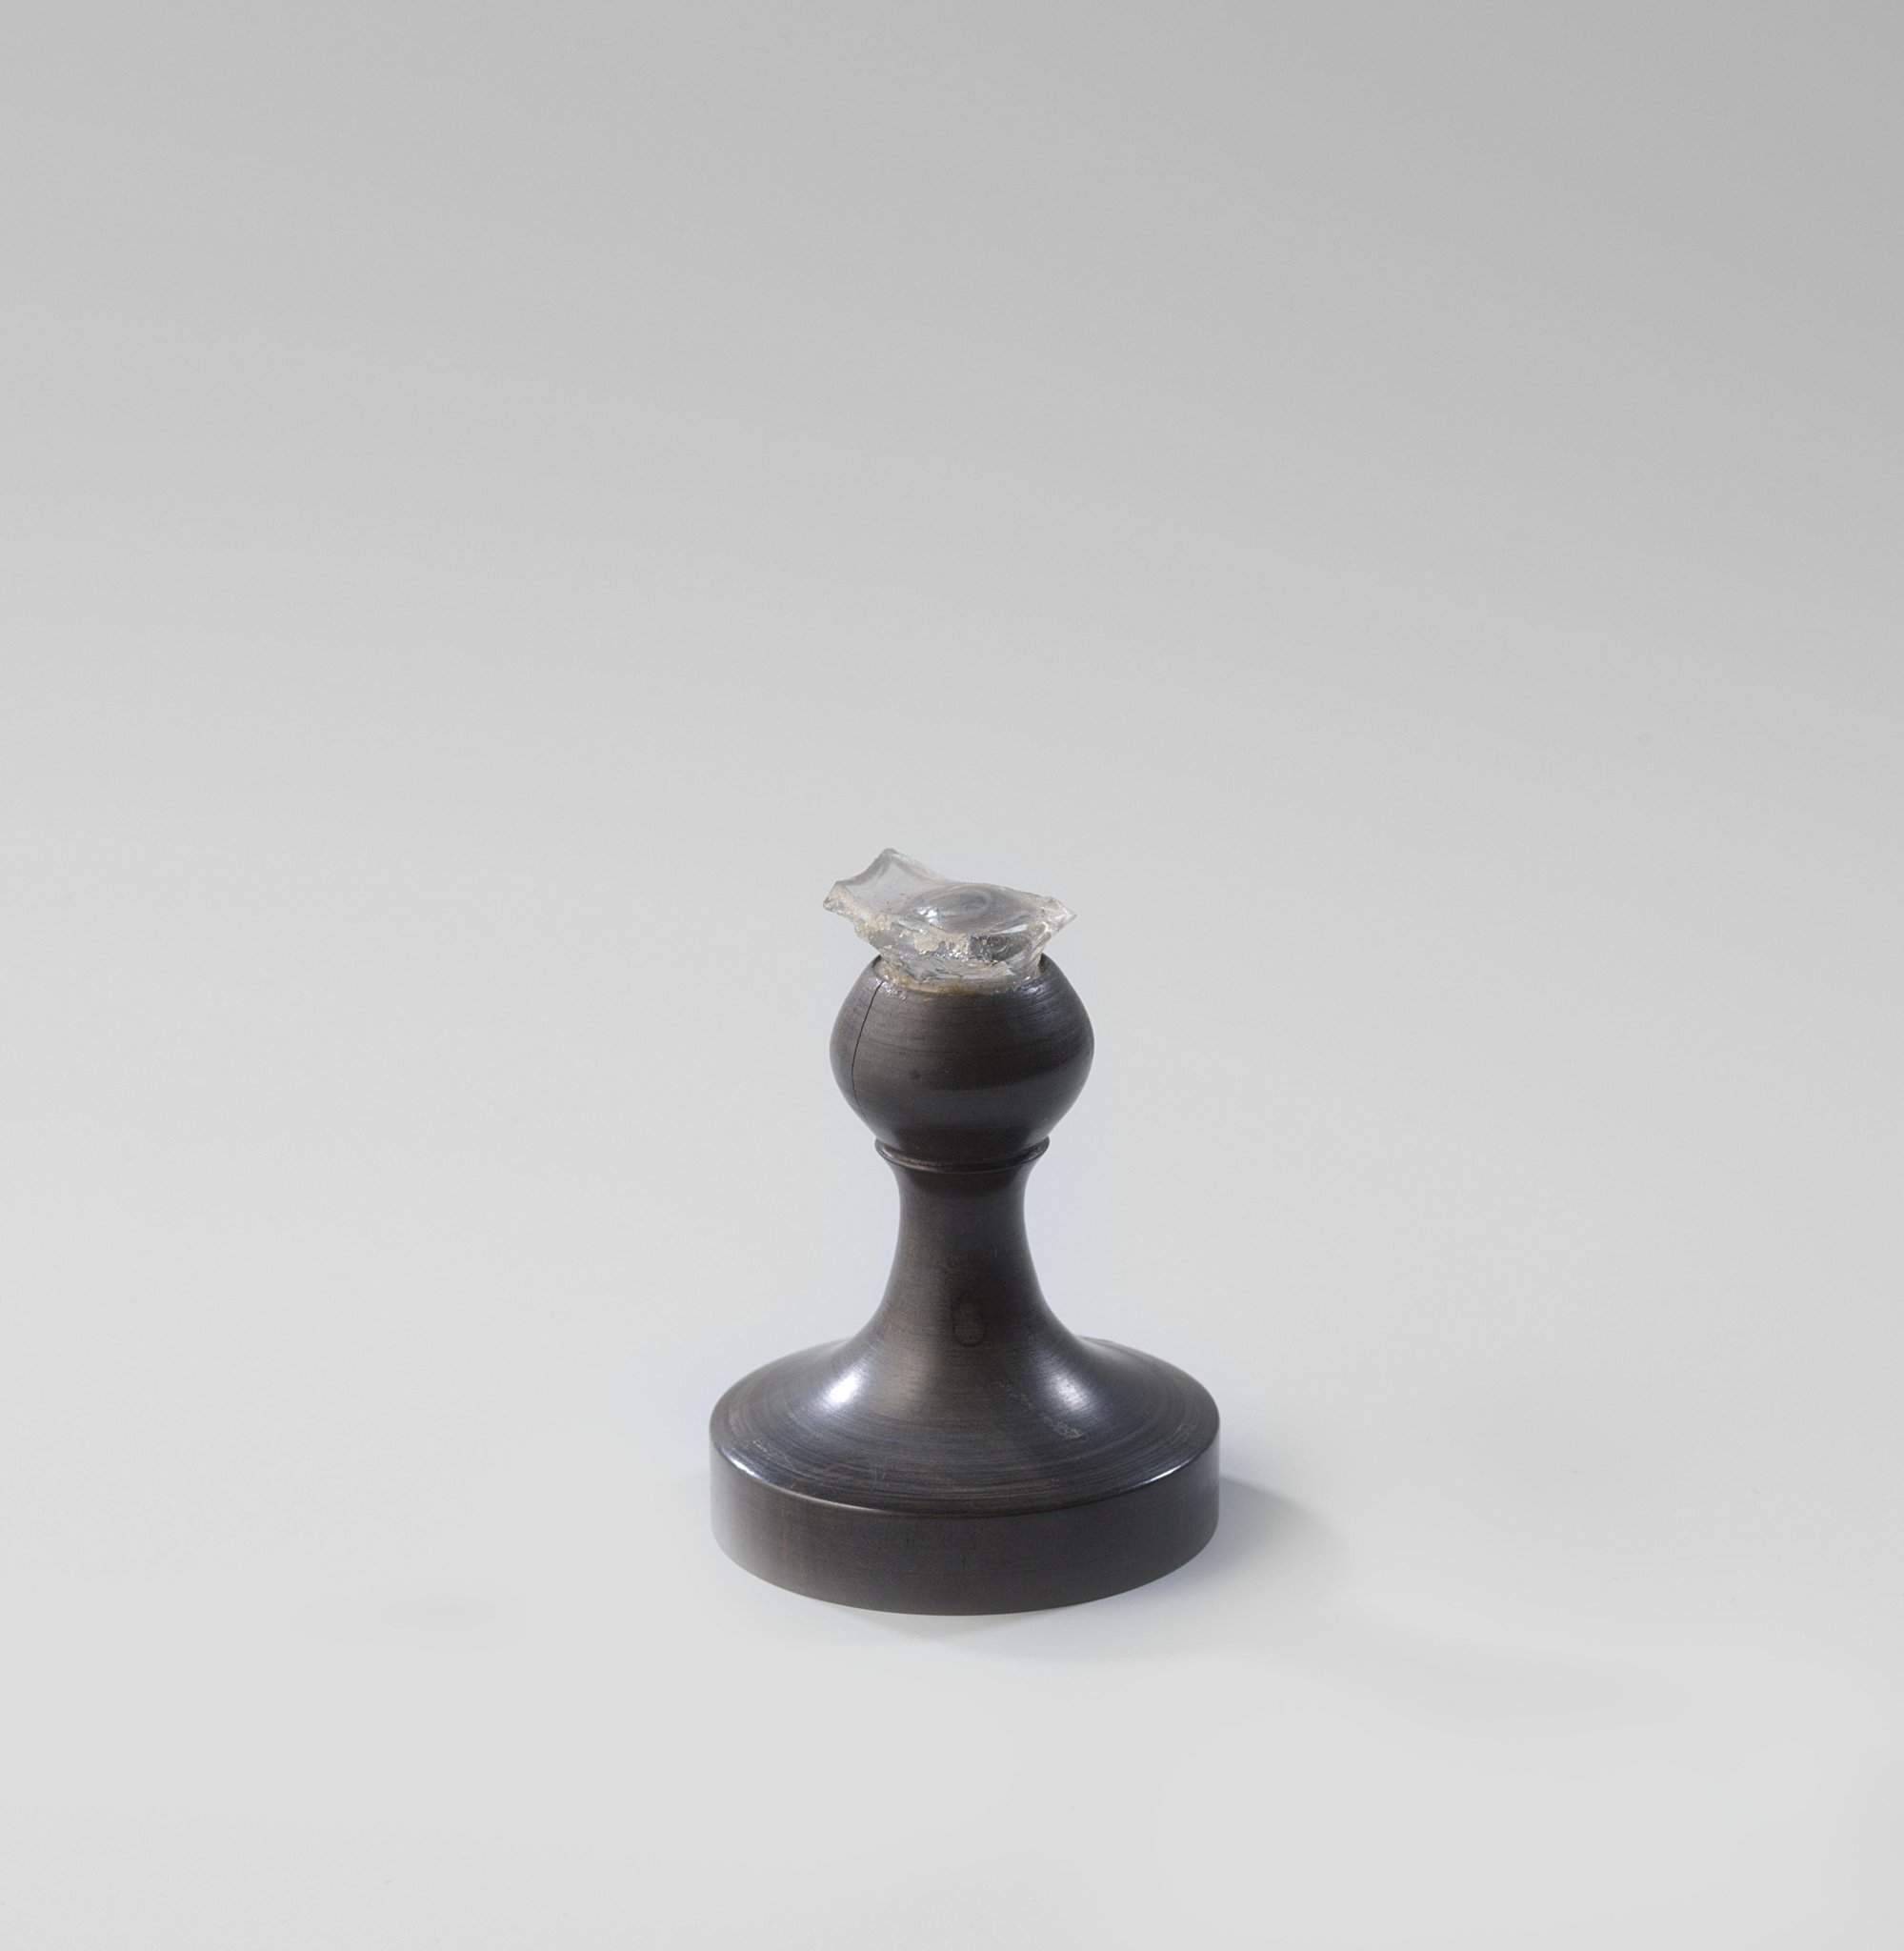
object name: goblet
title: Voet, stam en een deel van de kelk van een kelkglas (met een galopperend paard en het opschrift: Aurea Libertas)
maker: Anonymous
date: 1700-1800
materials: glass, wood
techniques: diamond point engraving, engraving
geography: northern netherlands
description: Houten voet en stam. Oorspronkelijk was de kelk van onderen rond en verwijdde zich met zacht gebogen, bij de opening een weinig buitenwaarts lopende lijn. Op de kelk was een galopperend paard gegraveerd onder een gestipte spreukband met de tekst: 'Aurea Libertas' in uitgespaarde letters. Geheel was gebarsten en gelijmd.